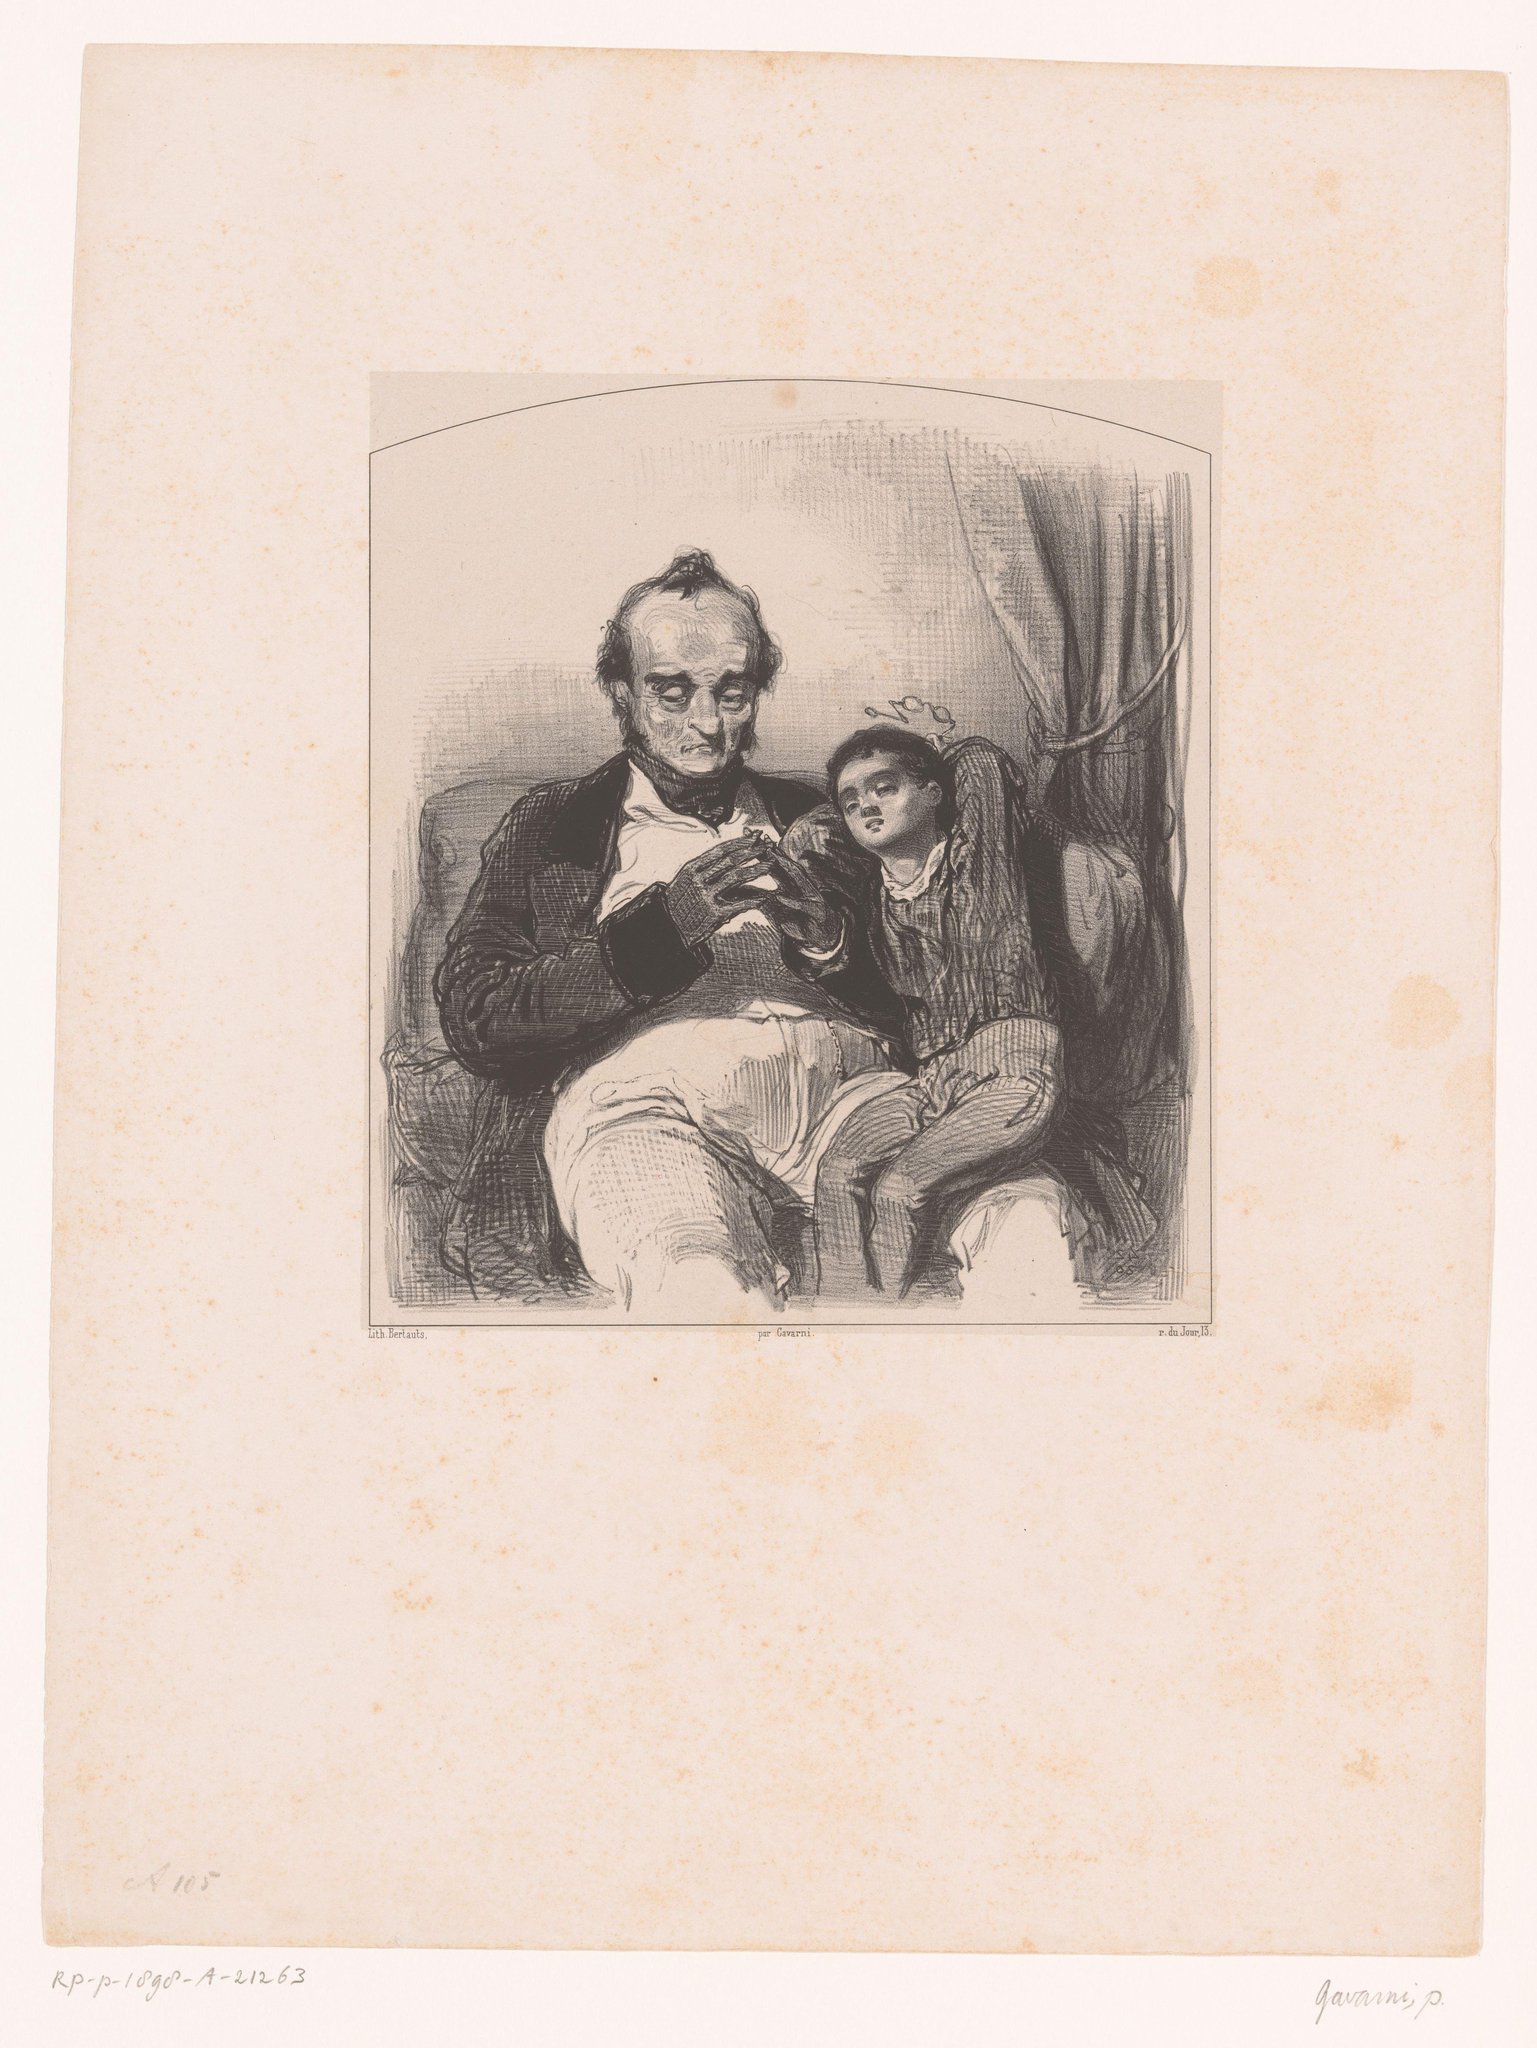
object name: print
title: Man met kind op schoot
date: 1842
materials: paper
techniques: lithograph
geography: paris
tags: mischief-making play, boy (child between toddler and youth), father and son(s) (family group) (with number of sons)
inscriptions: collector's mark: Lugt 964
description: Het kind houdt de bril van de man achter zijn hoofd.